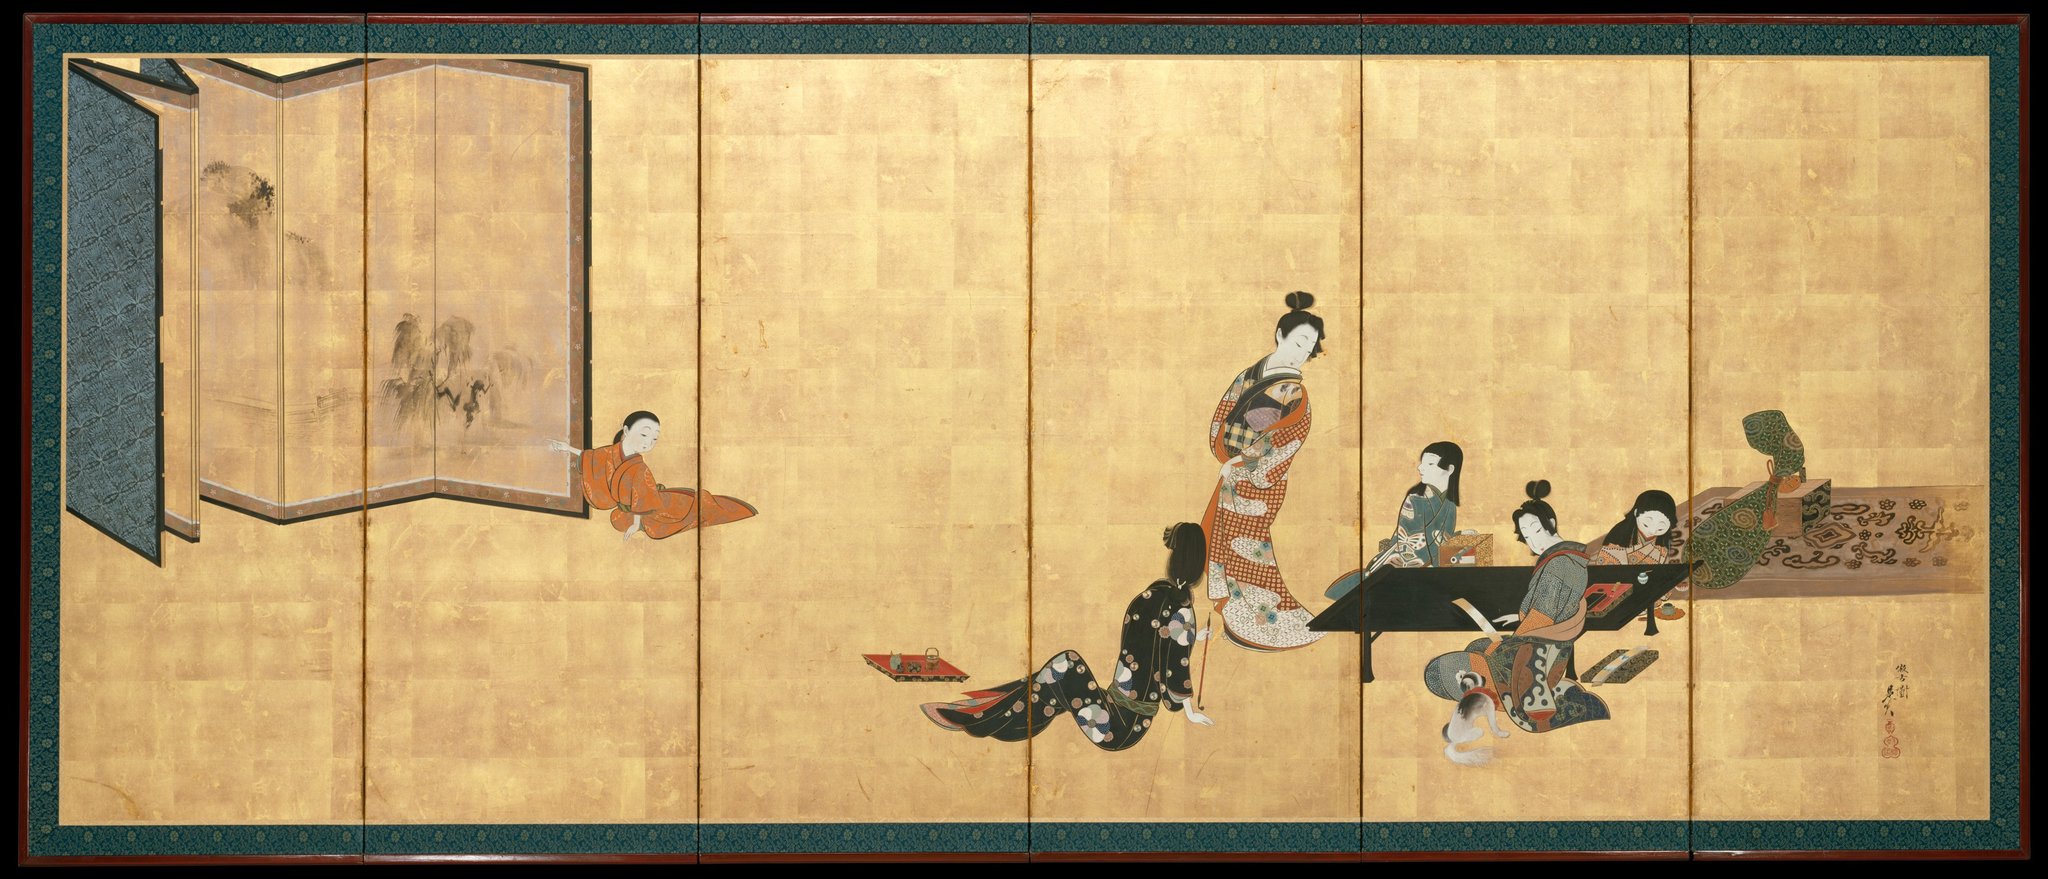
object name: screen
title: Parody of the Four Accomplishments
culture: japanese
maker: shibata zeshin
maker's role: artist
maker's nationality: japanese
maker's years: 1807-1891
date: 1851-1900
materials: gold leaf, ink, panel, paper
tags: men,women